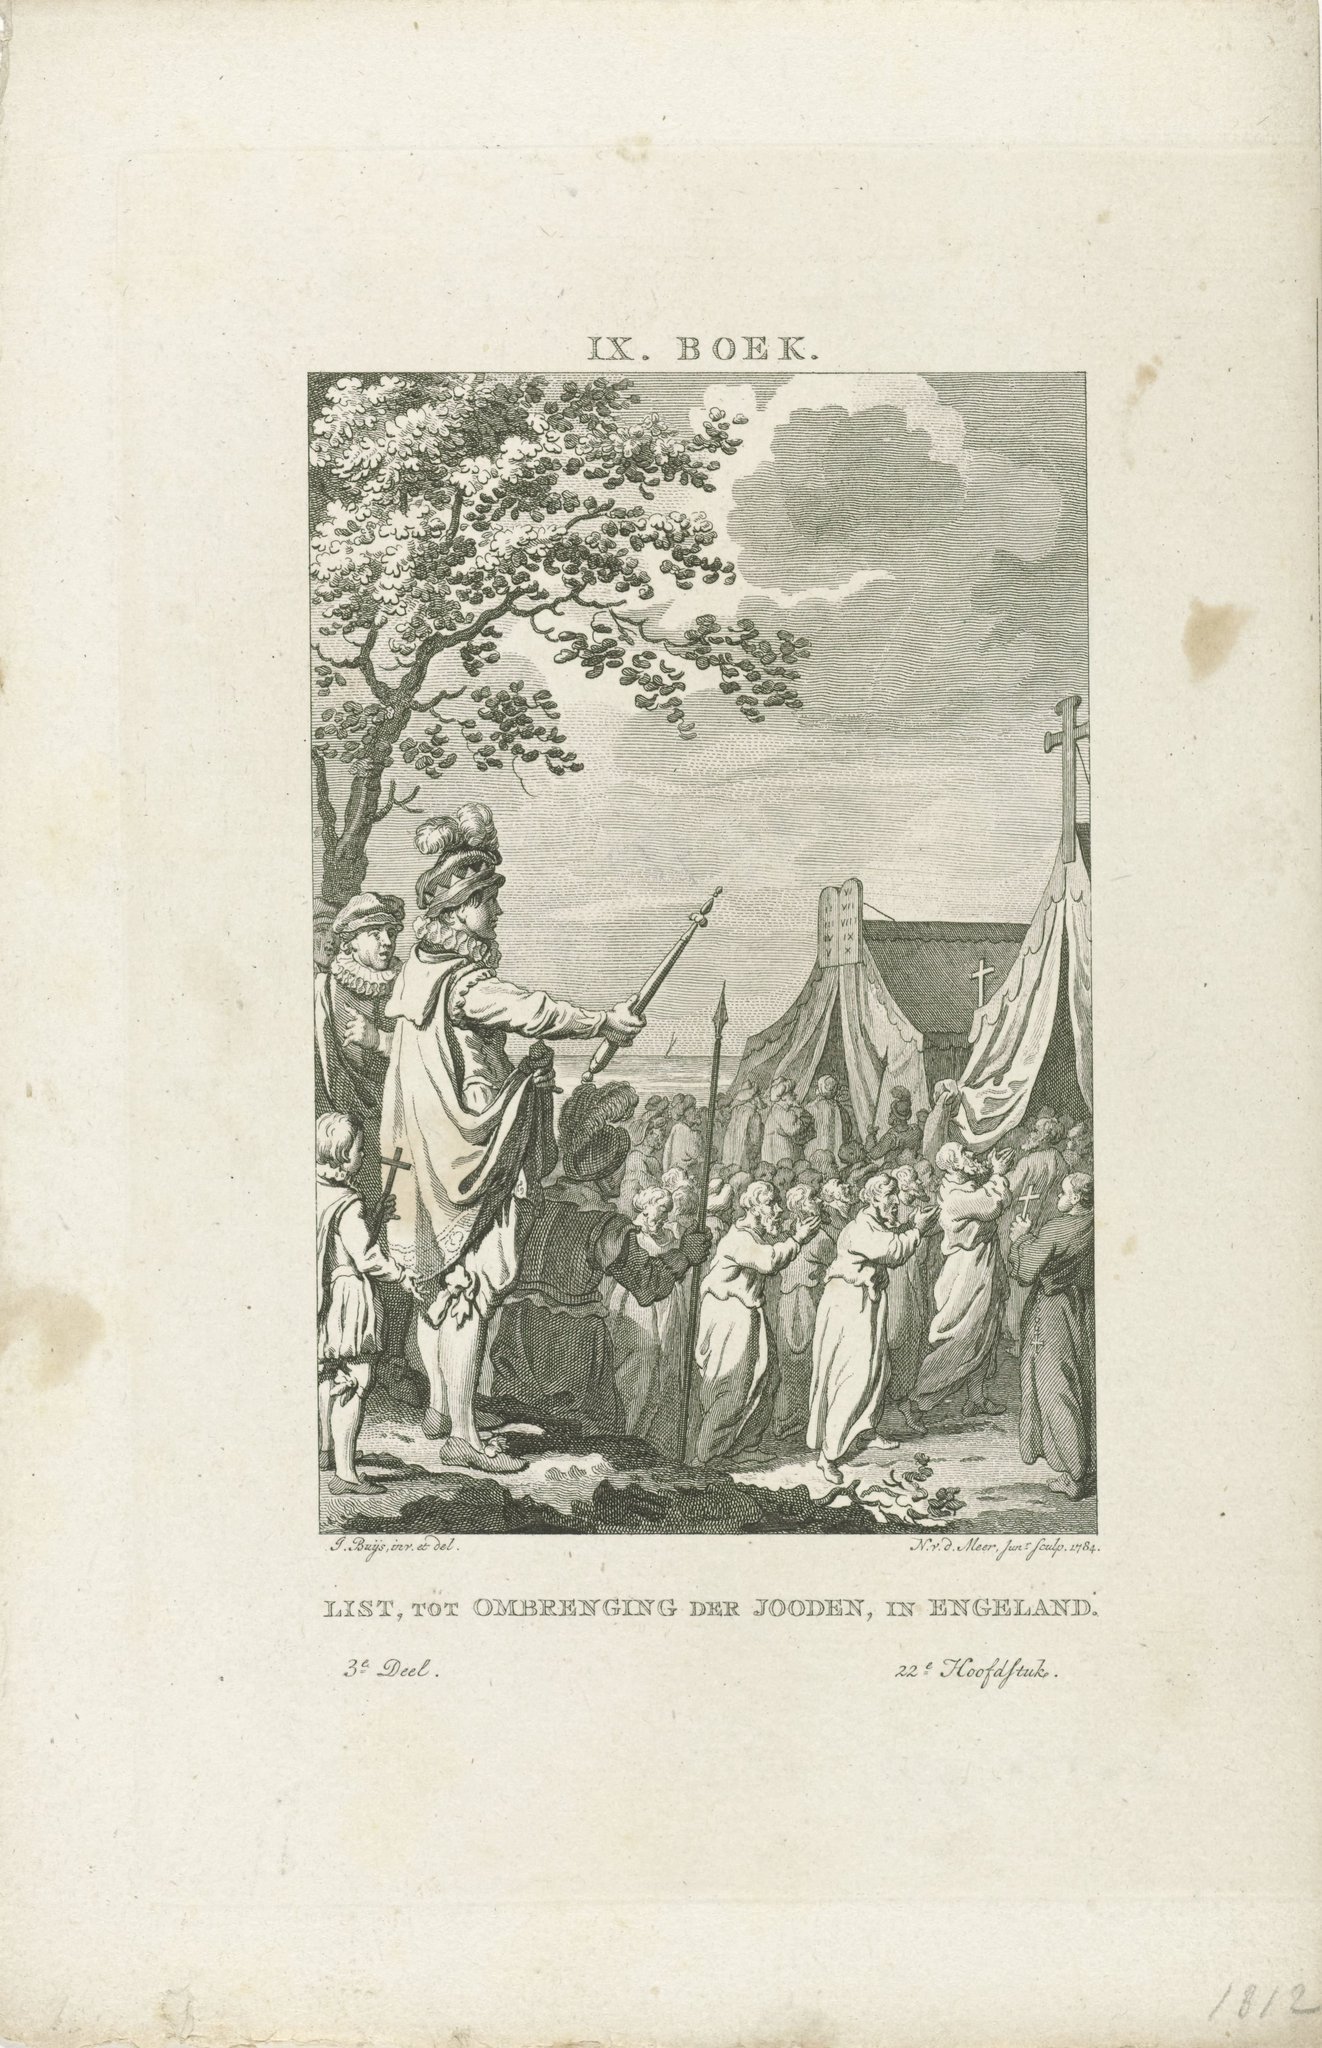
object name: print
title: List, tot ombrenging der Joden, in Engeland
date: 1784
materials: paper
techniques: etching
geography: amsterdam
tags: tent, anti-semitism, cross as symbol of christ, ruler, sovereign, the ten commandments represented together on stone tablets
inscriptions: collector's mark: Lugt 2228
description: Vervolging van de Joden in Engeland. Onder toezicht van een vorst, met een bevelhebberstaf in zijn hand, loopt een groep mensen met de handen gevouwen een tent binnen. Boven de ingang van de tent is een kruis geplaatst. Op de achtergrond loopt een groep mensen een tent binnen. Hier zijn de tafelen der wet boven de ingang geplaatst.